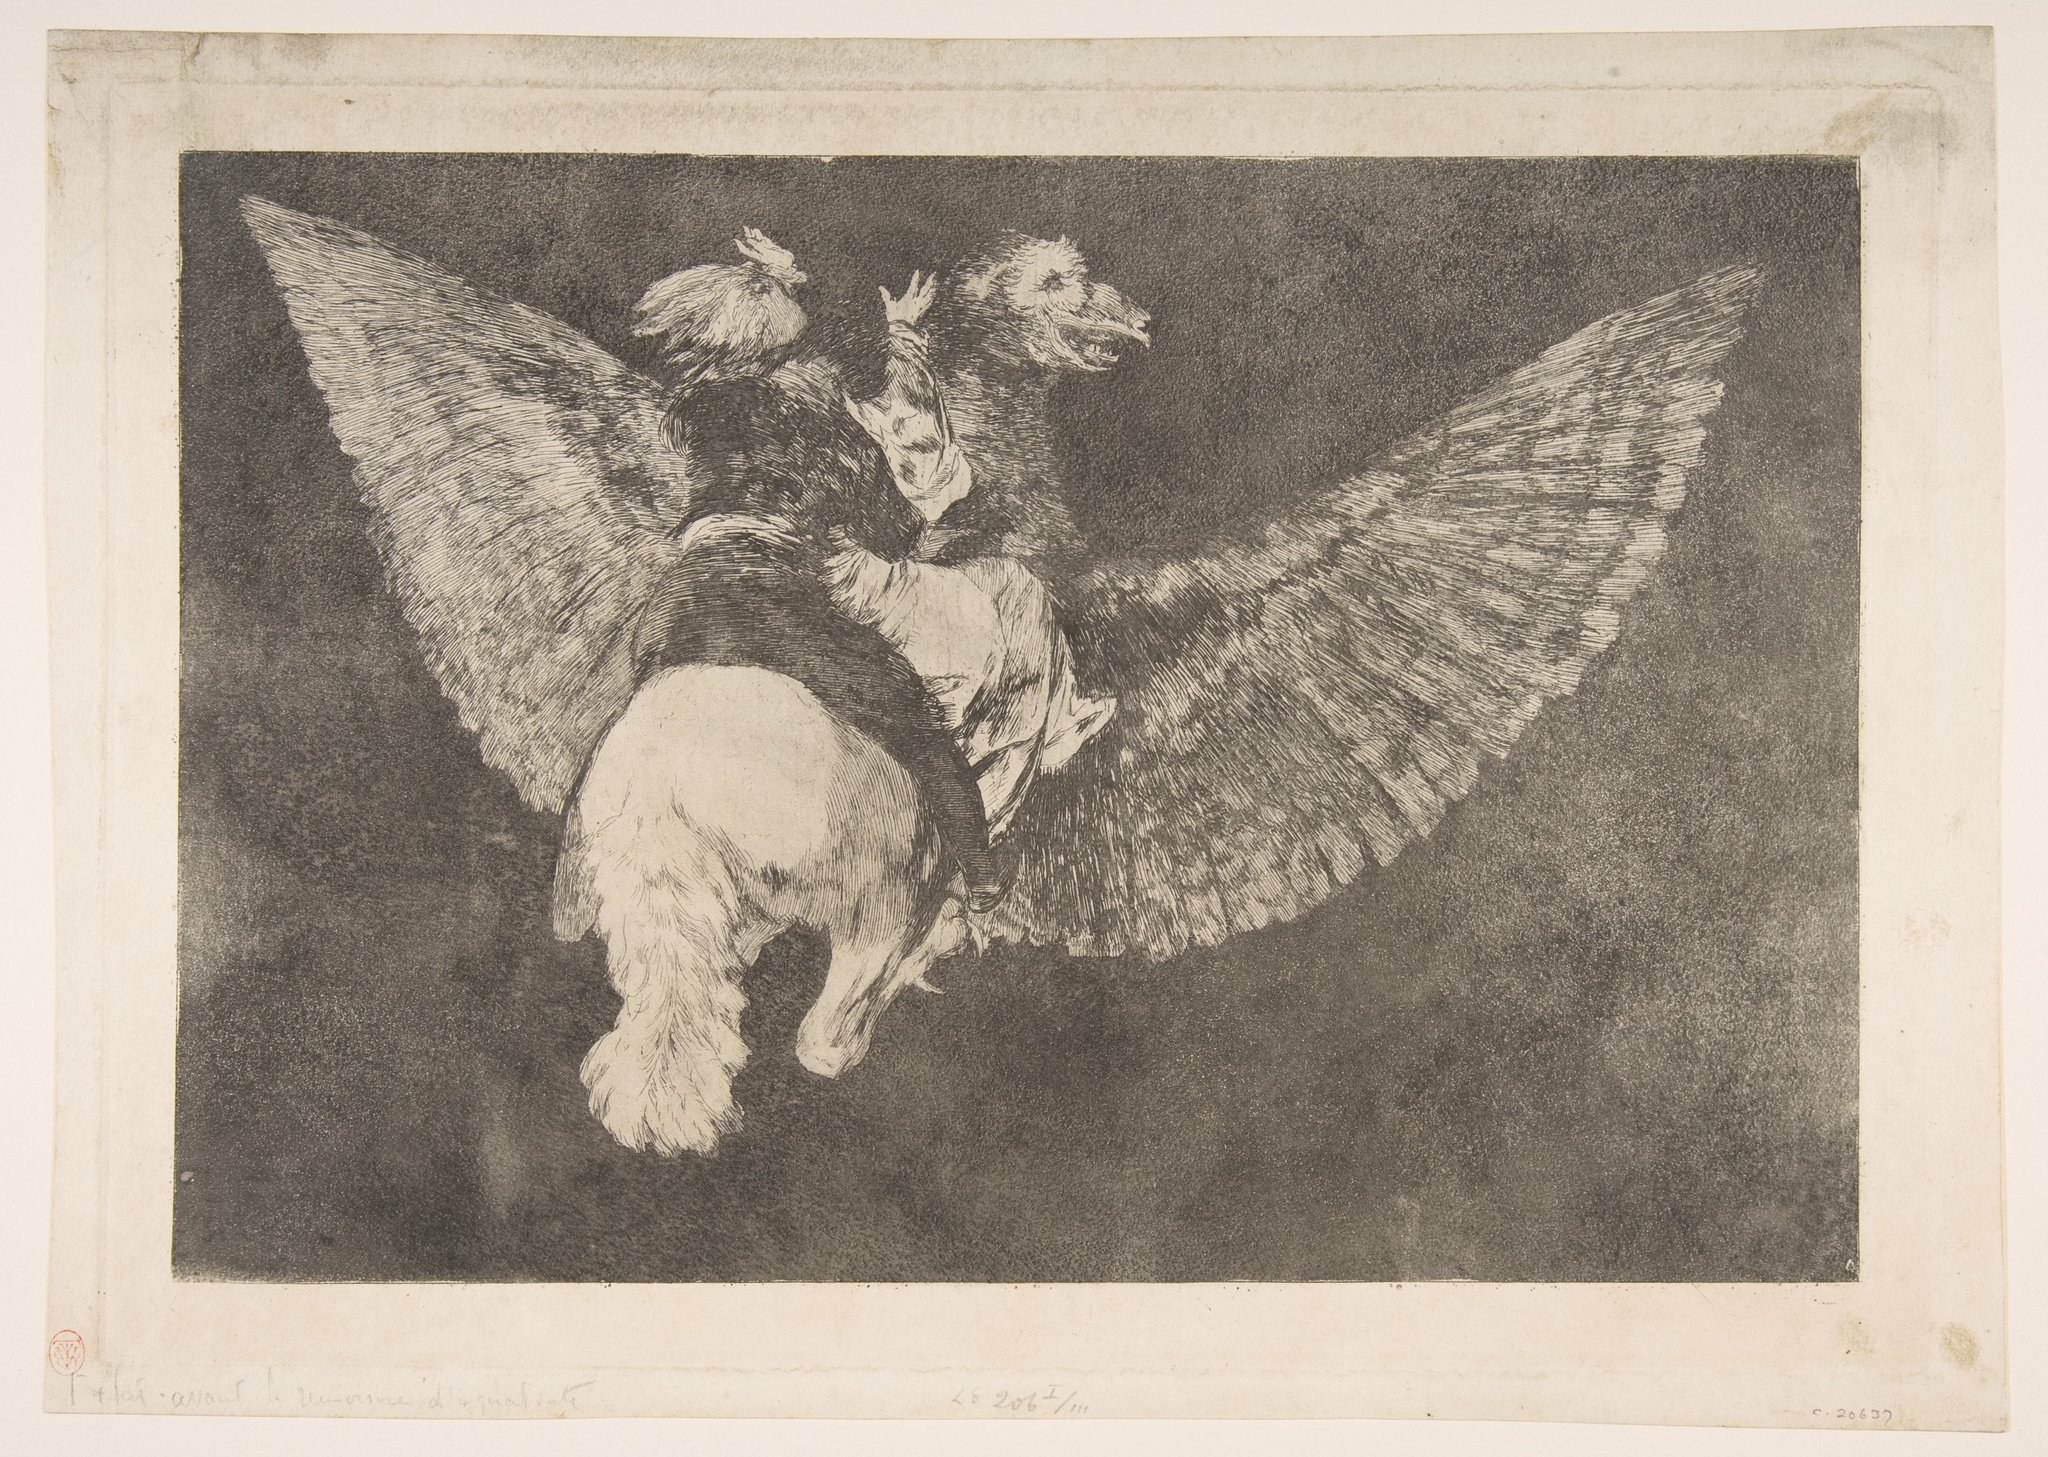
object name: print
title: 'Flying Folly' from the 'Disparates' (Follies / Irrationalities)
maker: goya (francisco de goya y lucientes)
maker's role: artist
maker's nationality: spanish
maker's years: 1746-1828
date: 1815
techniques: aquatint, etching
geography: spain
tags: human figures